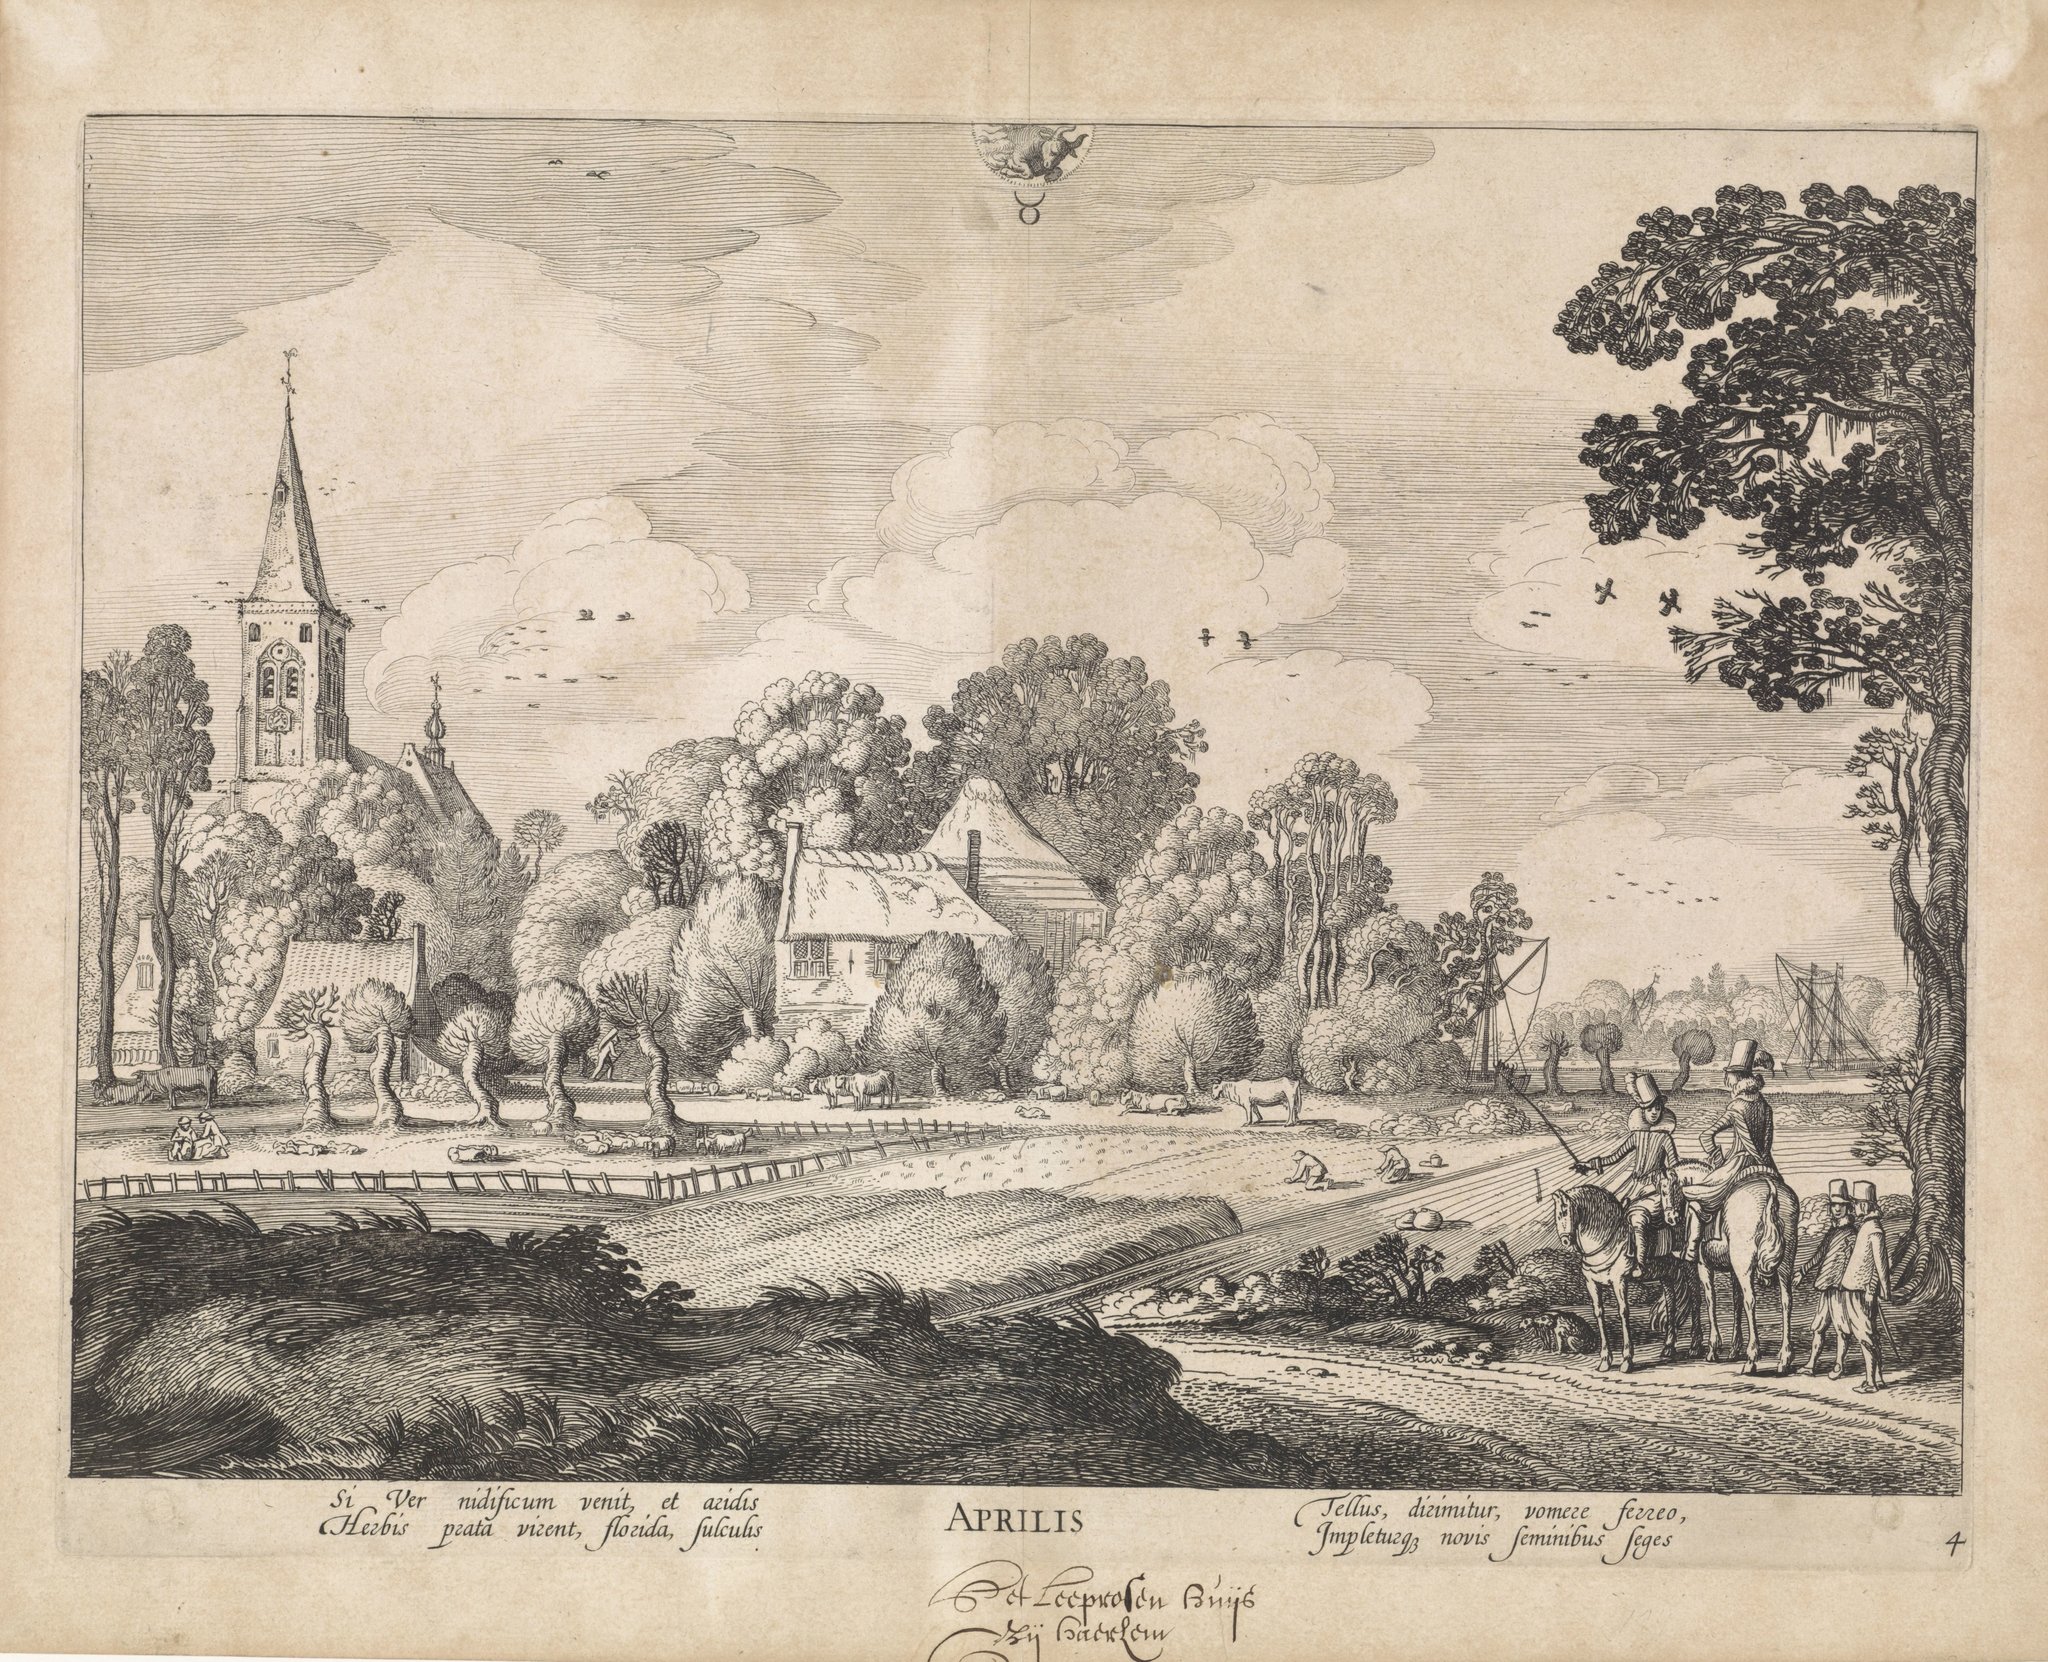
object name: print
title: April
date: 1618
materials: paper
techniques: etching, pen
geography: northern netherlands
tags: landscape symbolizing april, taurus (zodiacal sign of april), april and its 'labours', cultivation ~ agriculture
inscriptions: collector's mark: Lugt 2228, caption: ‘Het Leeprosen huys by Haerlem’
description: Landschap met akkerland, een weide met koeien en een omheinde weide met schapen. Links wordt gezaaid en geplant. Op de voorgrond rechts twee ruiters en twee lopende heren op een landweg. Linksachter een kerktoren achter bomenrij en een huis; het Leprozenhuis bij Haarlem, voorstellende de maand april. Bovenaan het bij deze maand behorende sterrenbeeld: stier. Vierde prent uit een serie van twaalf.